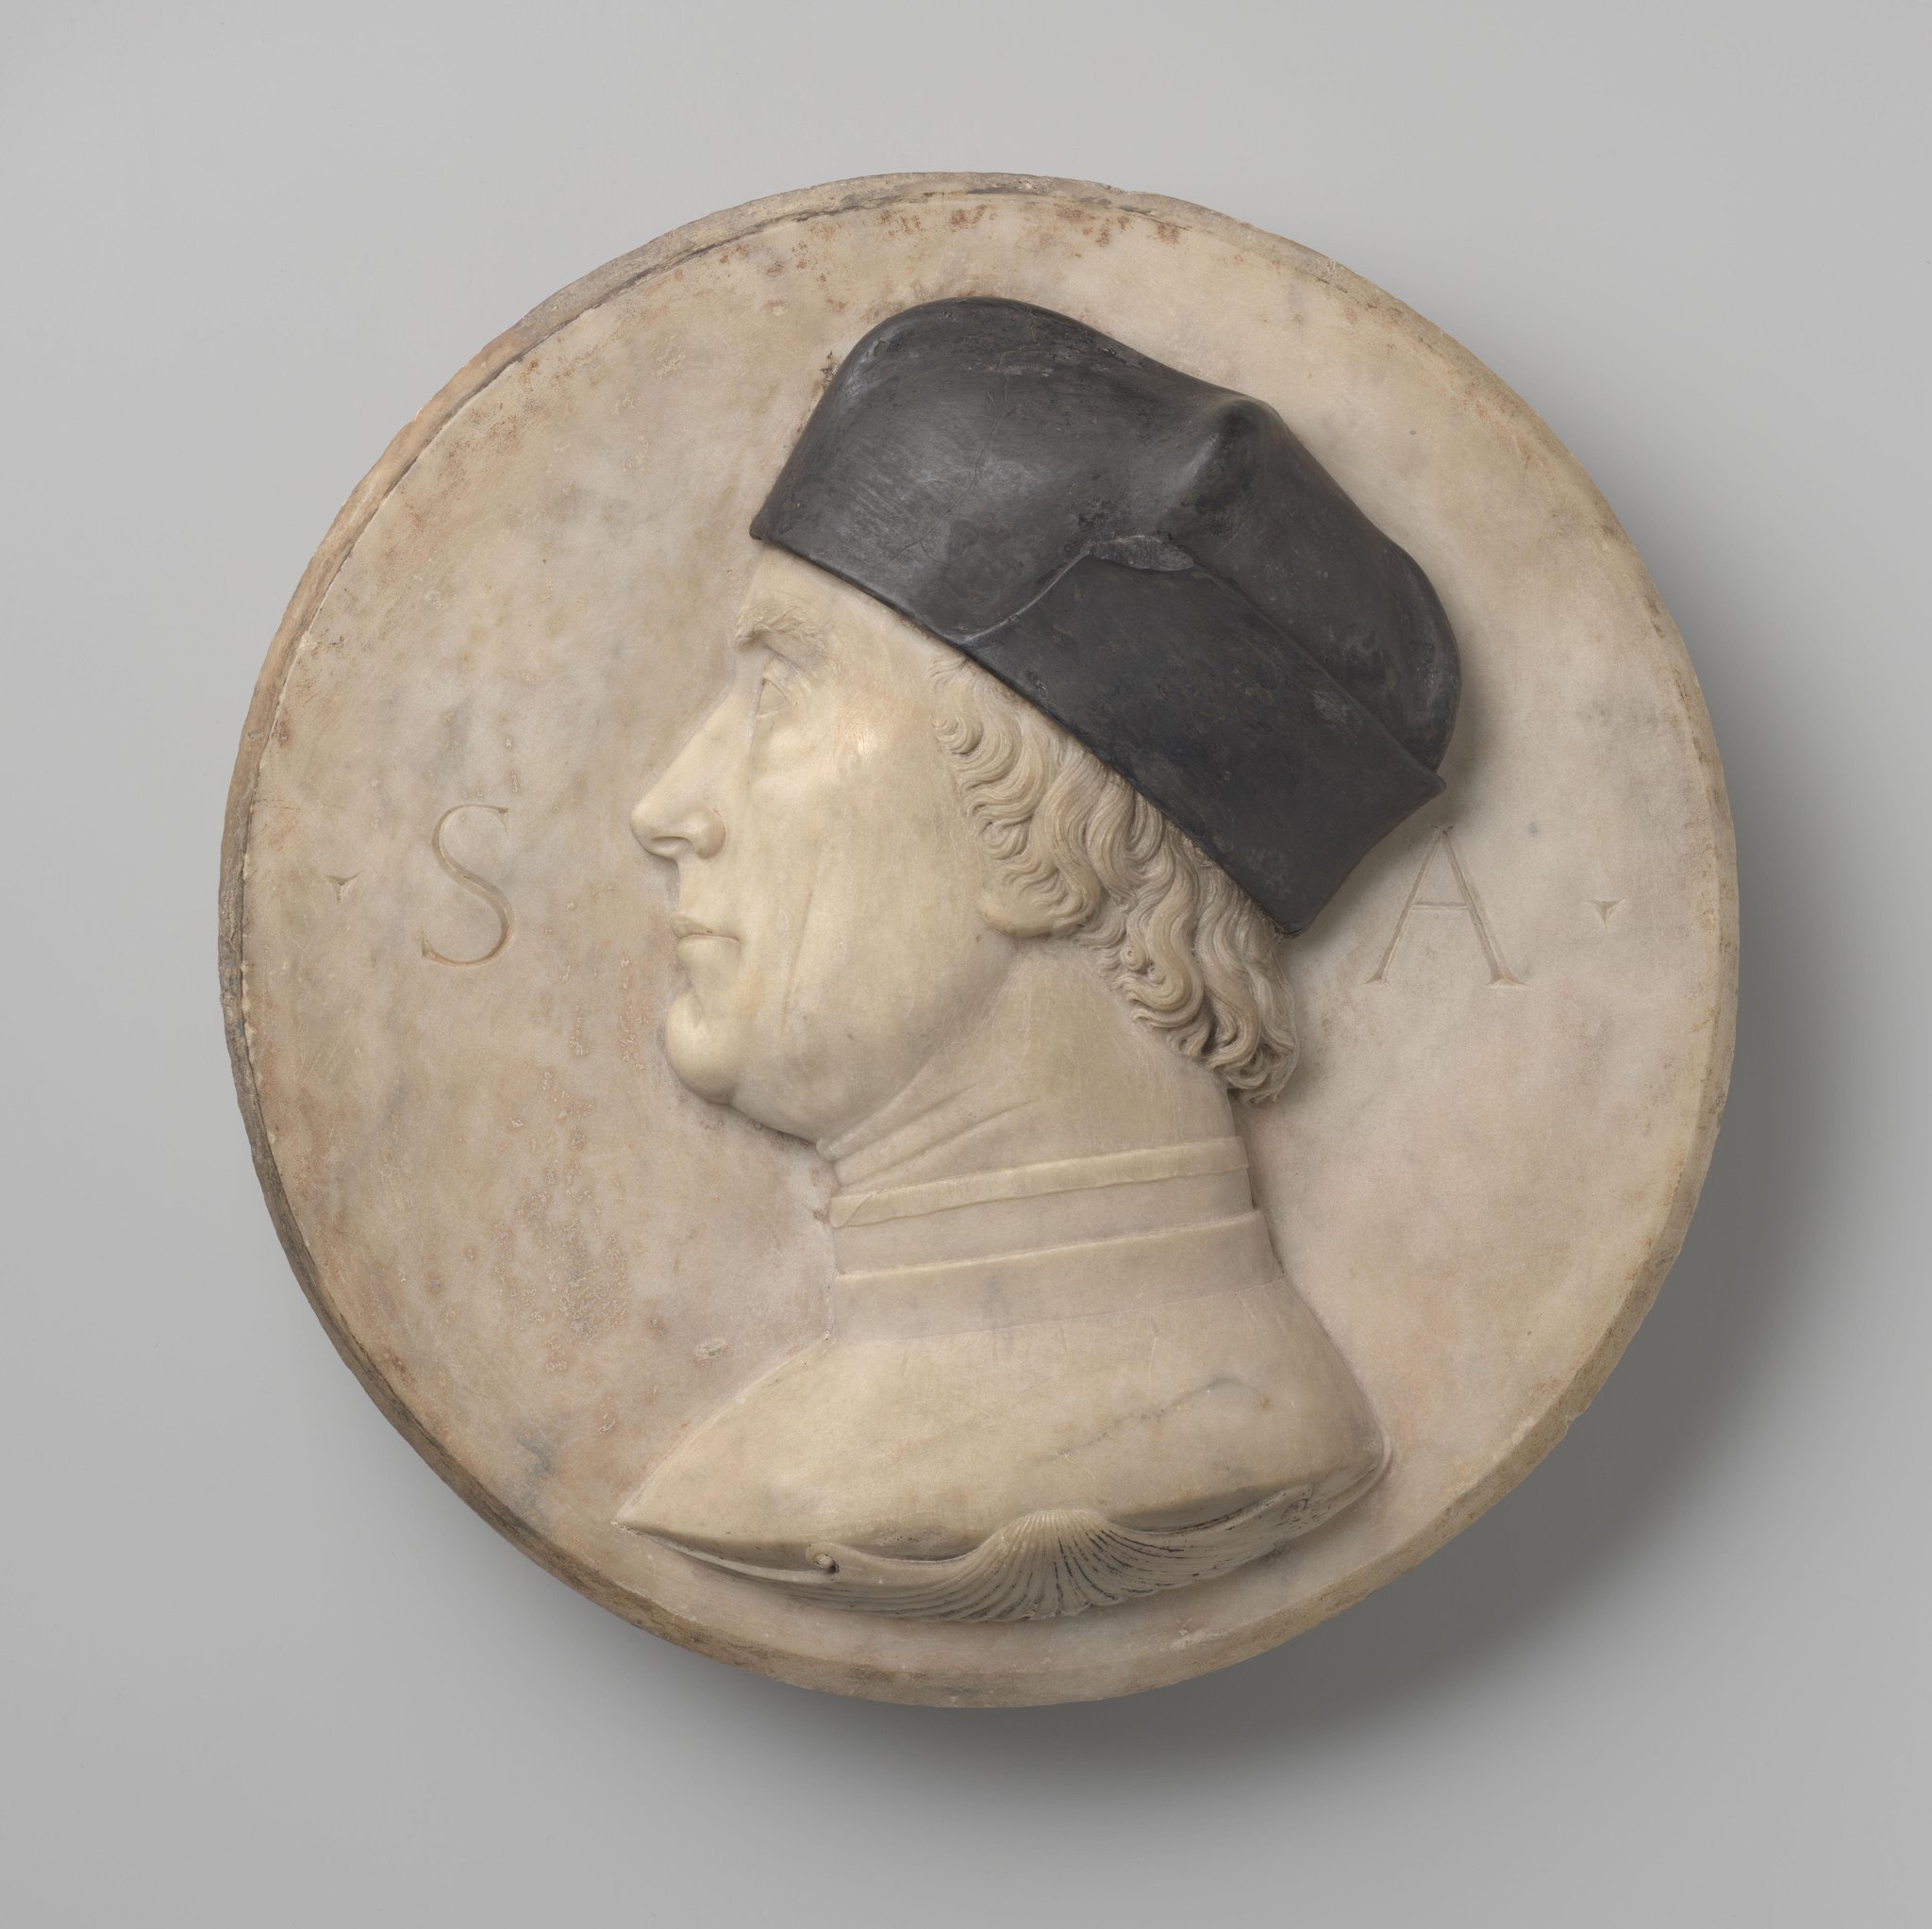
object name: sculpture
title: Portrait of a Man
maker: cristoforo solari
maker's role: sculptor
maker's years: 1468-1524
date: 1500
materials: marble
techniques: polychromy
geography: lombardy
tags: historical persons (+ profile portrait)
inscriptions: inscription: ‘SA’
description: Neither the maker of this medallion nor the person portrayed is known with certainty, even though the subject’s initials ‘SA’ appear in the background. With its sober style, this circular portrait resembles an ancient Roman coin. The use of two types of marble is unusual.